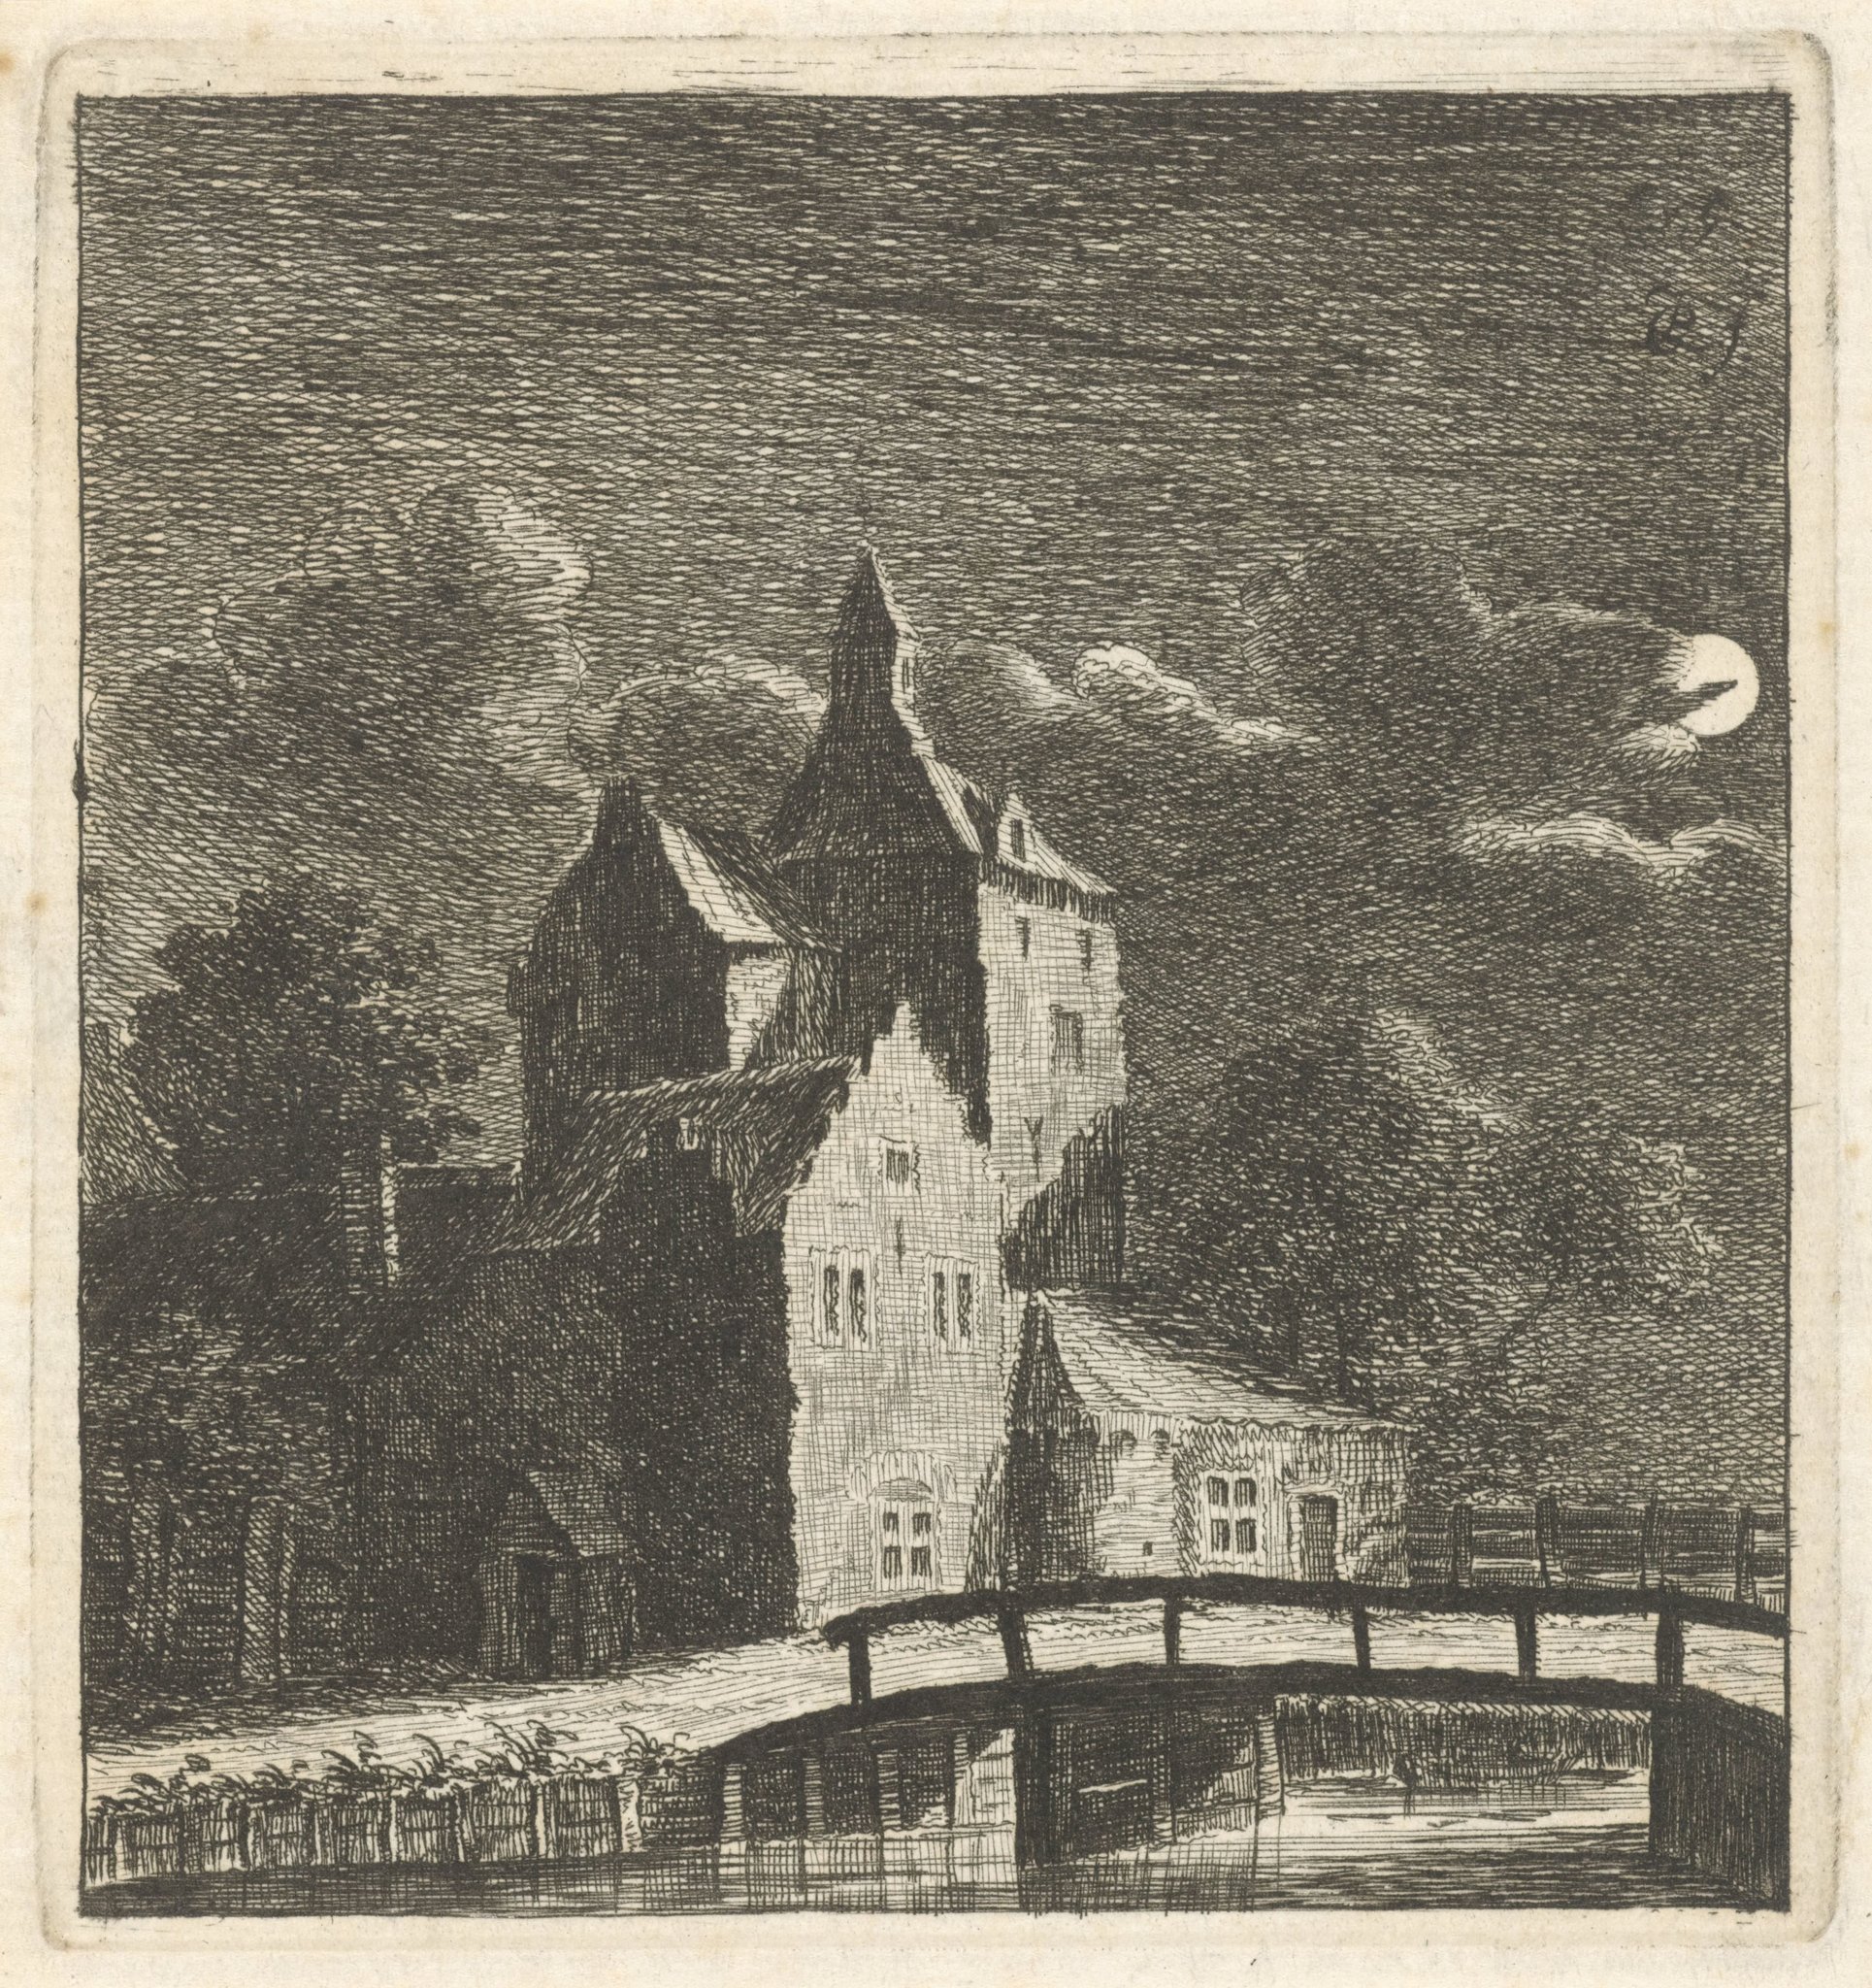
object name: print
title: Gezicht op een kasteel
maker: caspar jacobsz. philips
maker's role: draughtsman, print maker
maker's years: 1732-1789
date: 1766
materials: paper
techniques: etching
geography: amsterdam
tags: rural housing, e.g. country-house, villa, cottage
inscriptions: collector's mark: Lugt 240